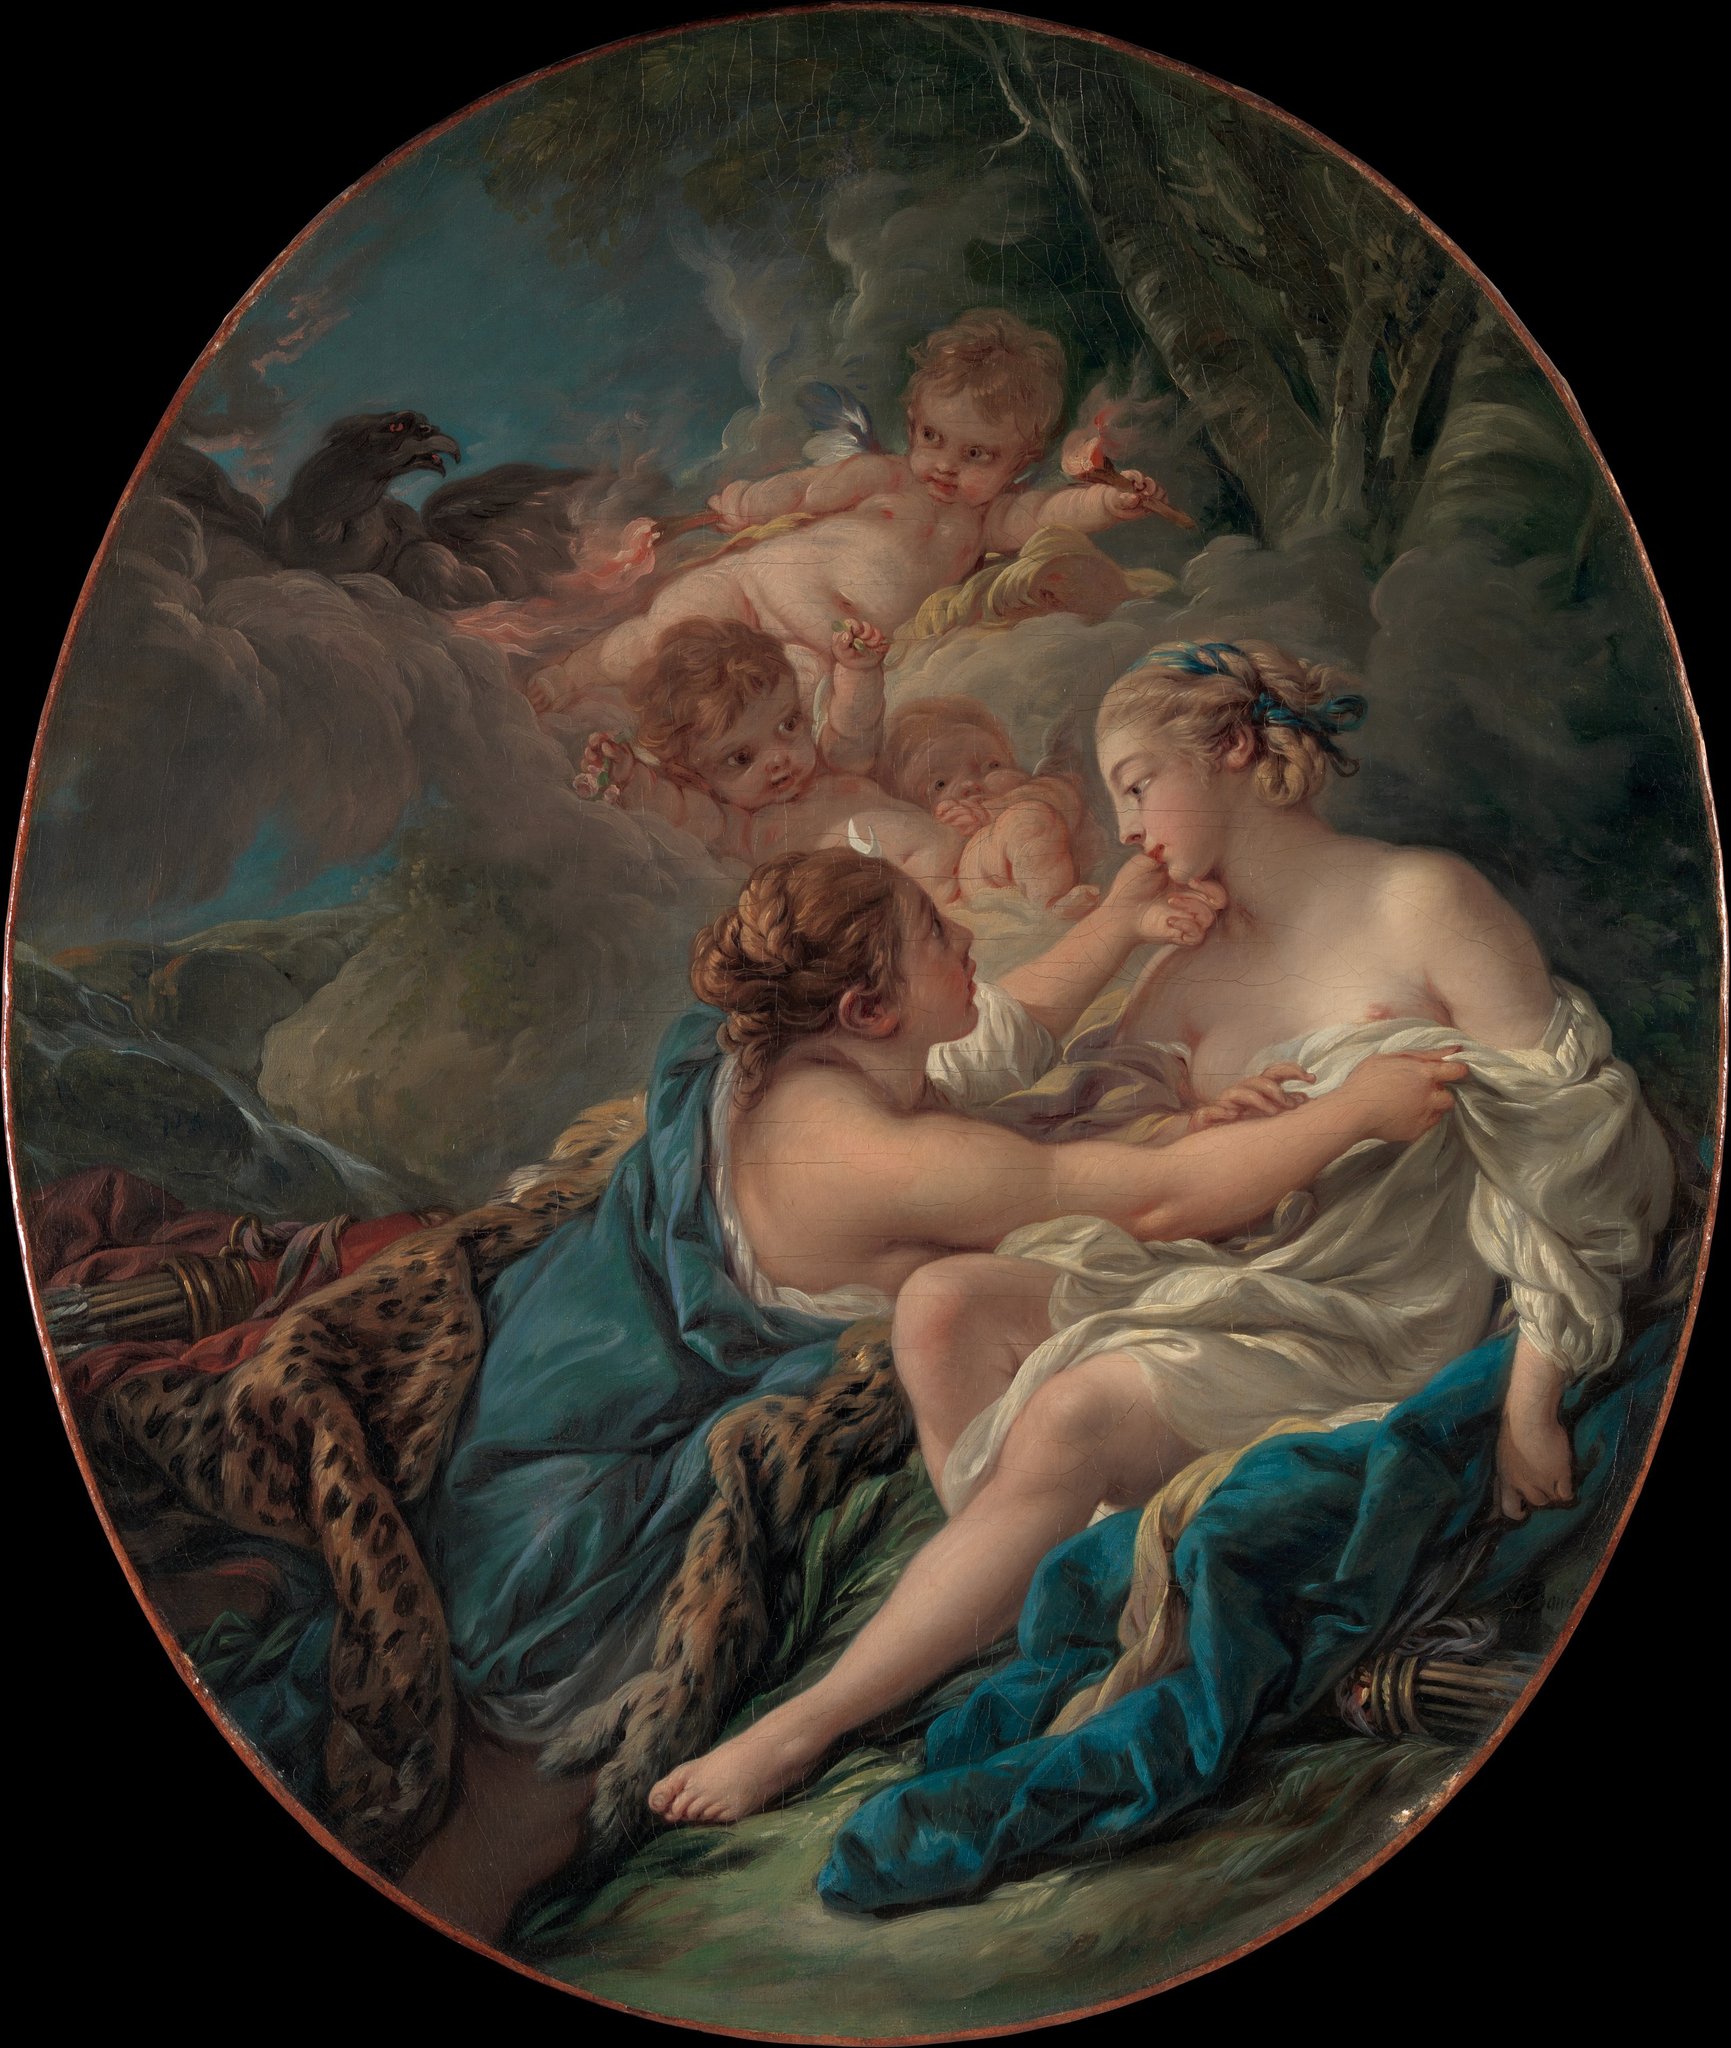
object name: painting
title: Jupiter, in the Guise of Diana, and Callisto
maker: françois boucher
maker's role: artist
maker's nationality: french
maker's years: 1703-1770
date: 1763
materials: canvas, oil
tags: putti,diana,jupiter